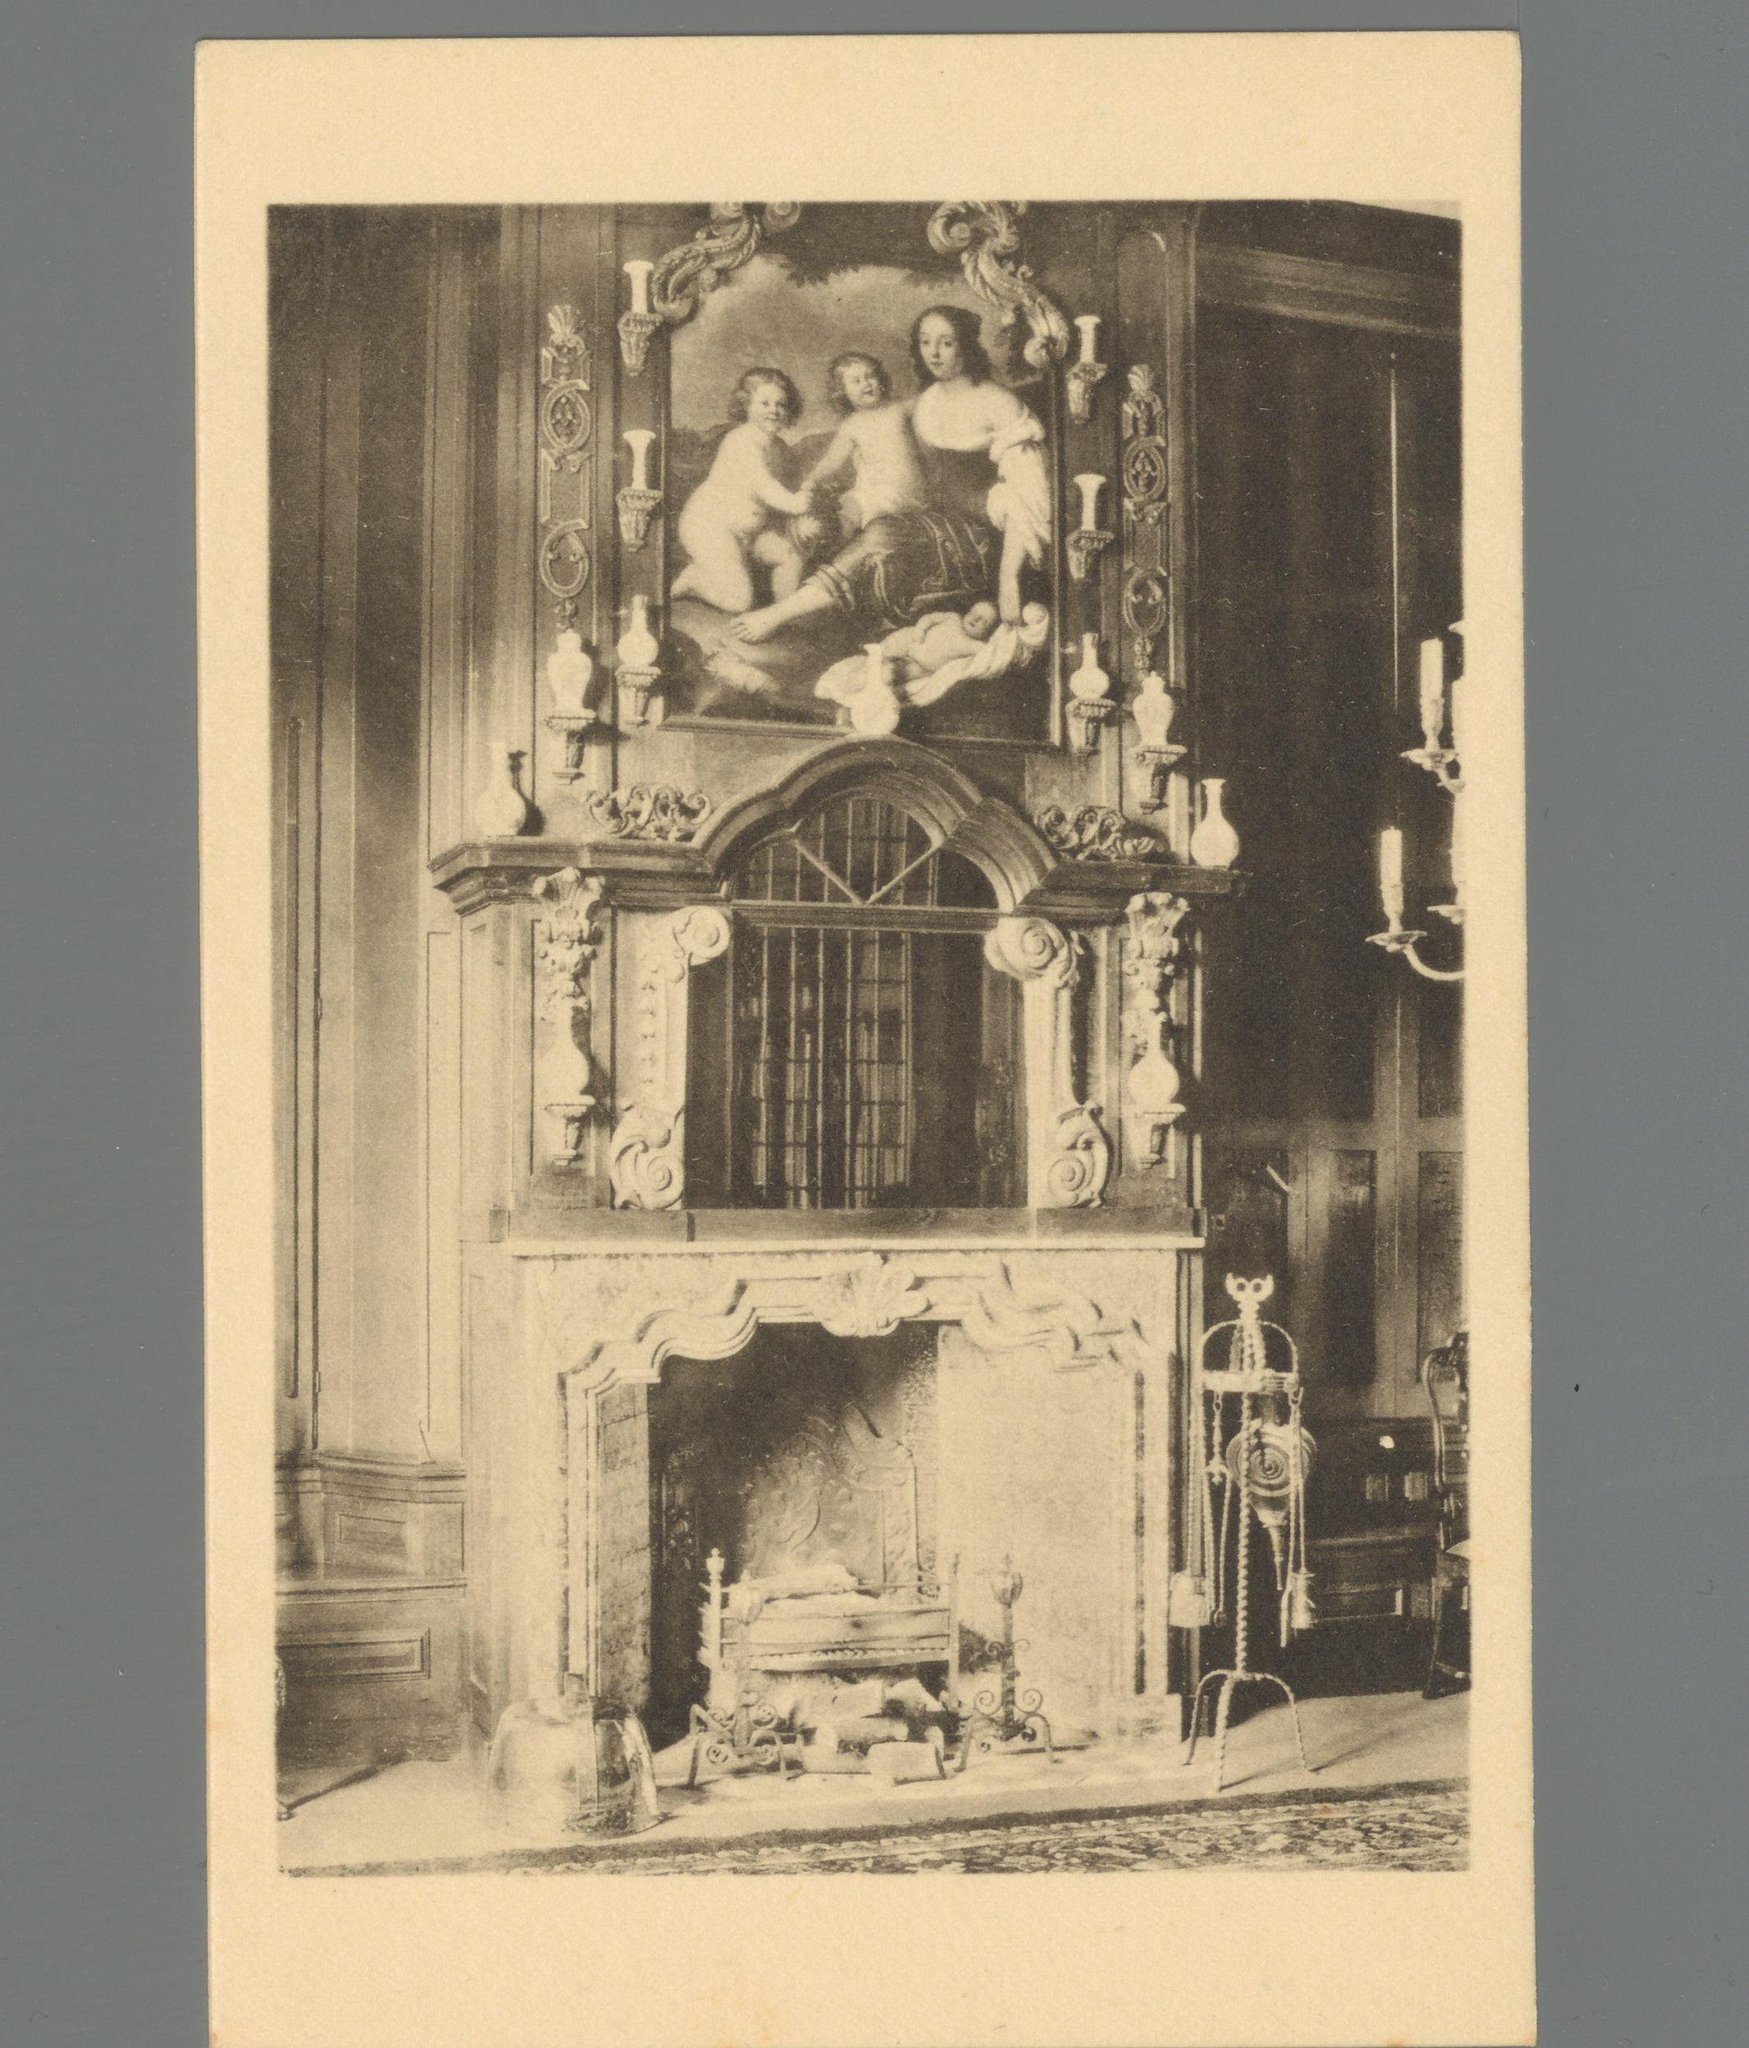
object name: ansichtkaart, prentbriefkaart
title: De Zonheuvel: Eetkamer schouw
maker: Anonymous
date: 1913-1950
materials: cardboard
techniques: photograph, writing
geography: doorn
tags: open hearth, fire-place, villa, dining-room